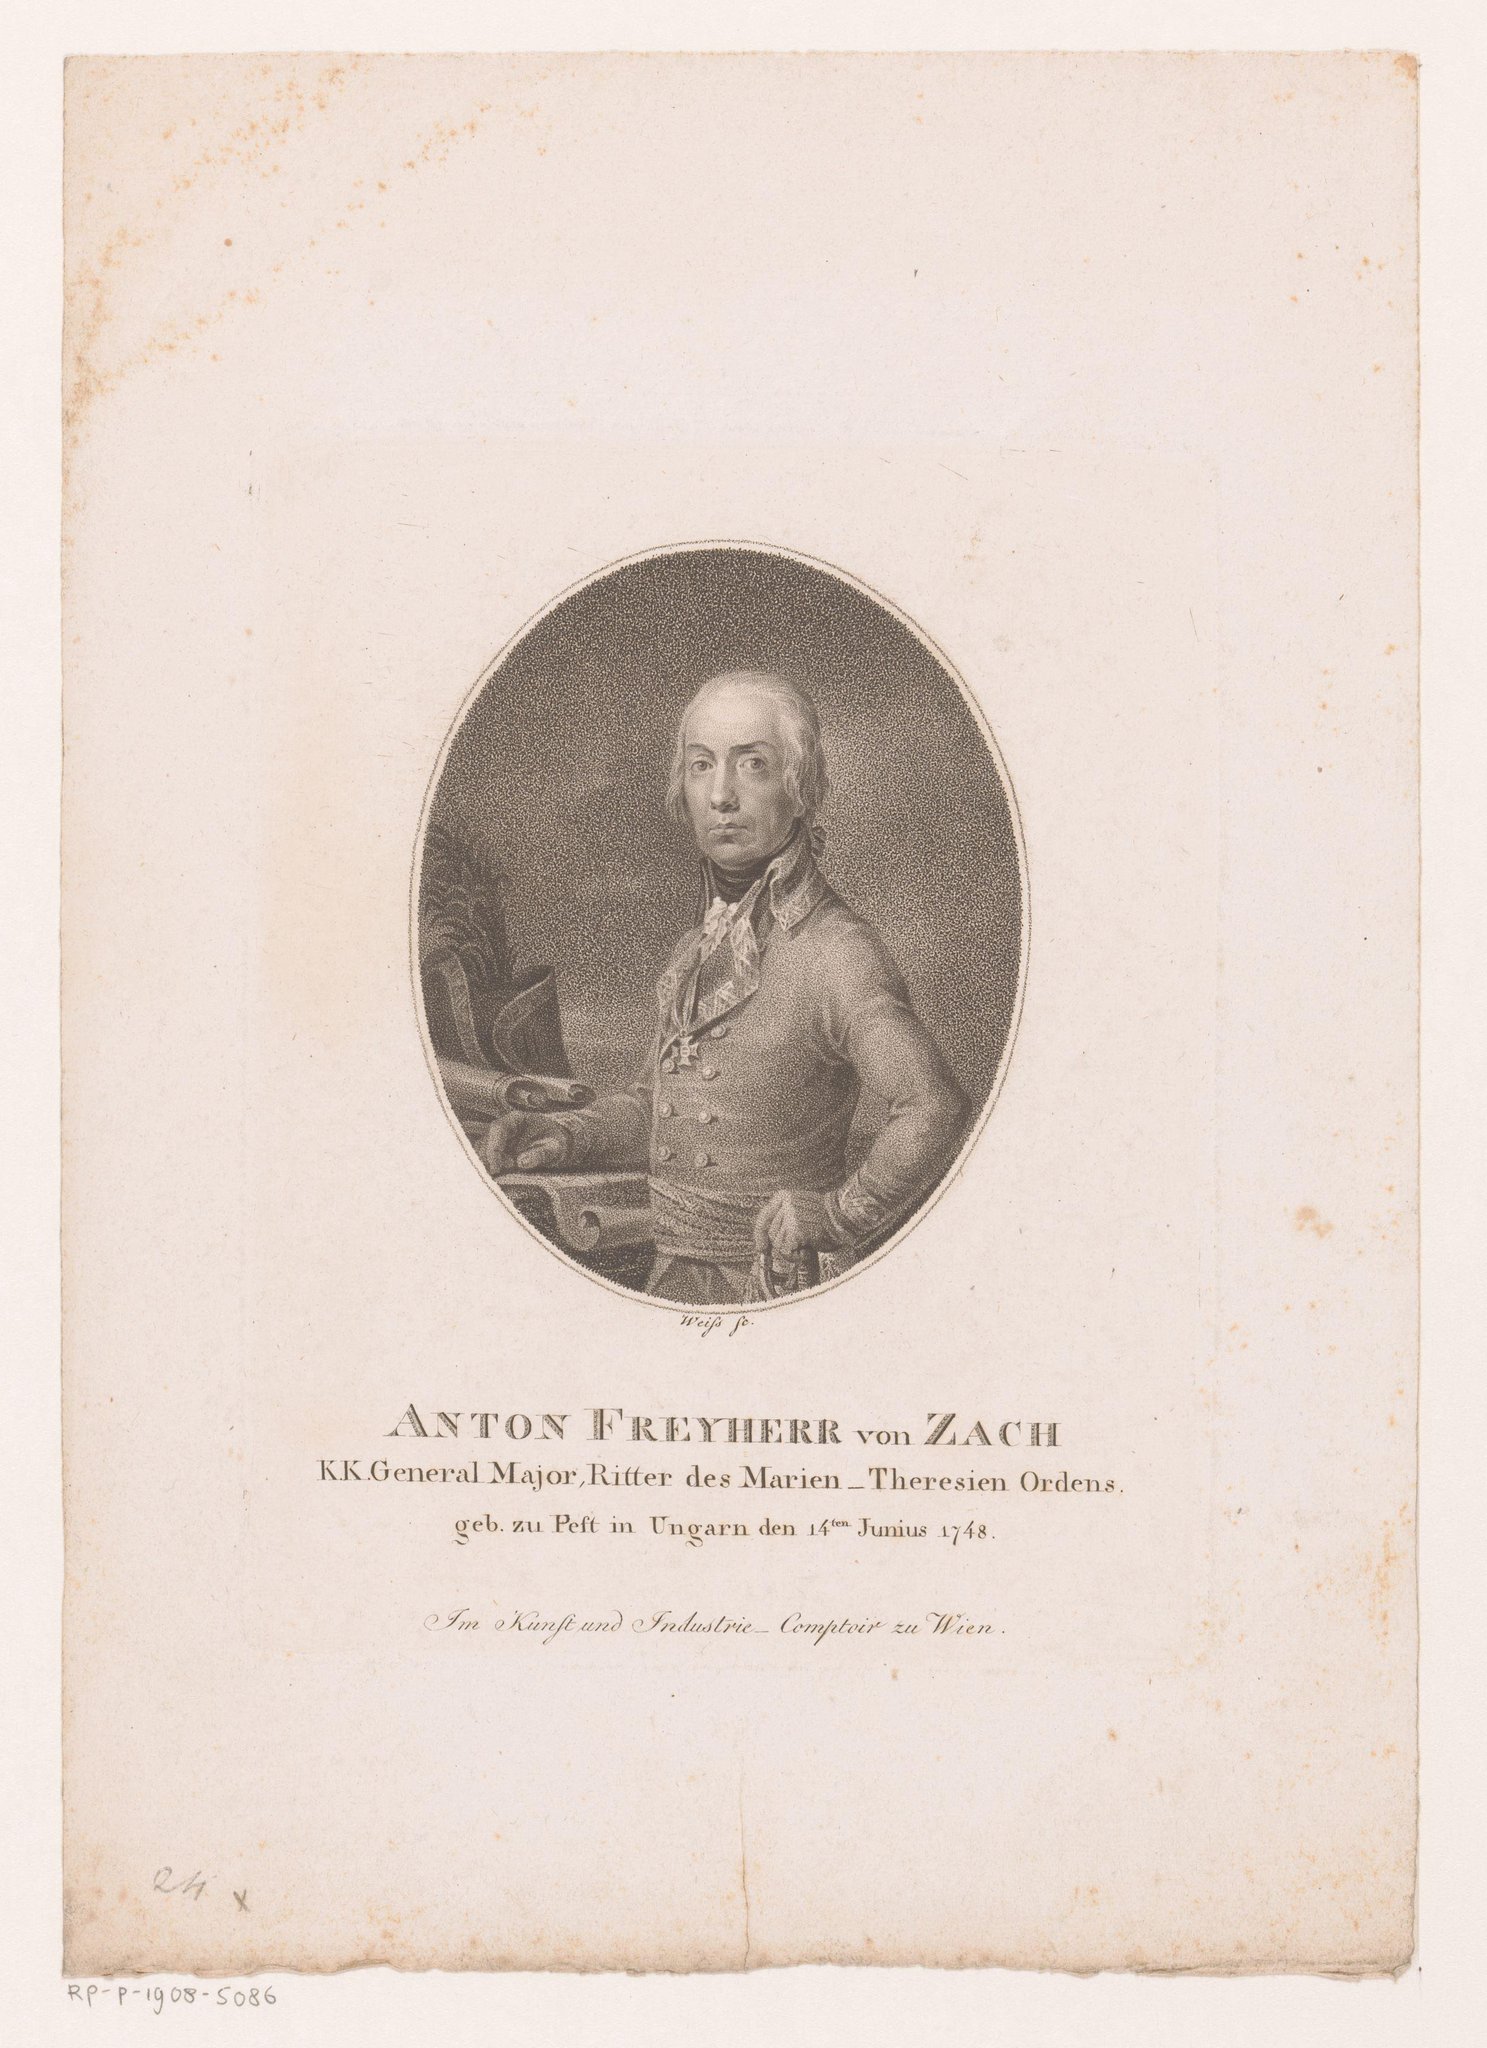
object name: print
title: Portret van Anton Freiherr von Zach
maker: david weiss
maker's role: print maker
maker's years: 1775-1846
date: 1785-1846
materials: paper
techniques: engraving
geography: vienna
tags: historical persons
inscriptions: collector's mark: Lugt 2228